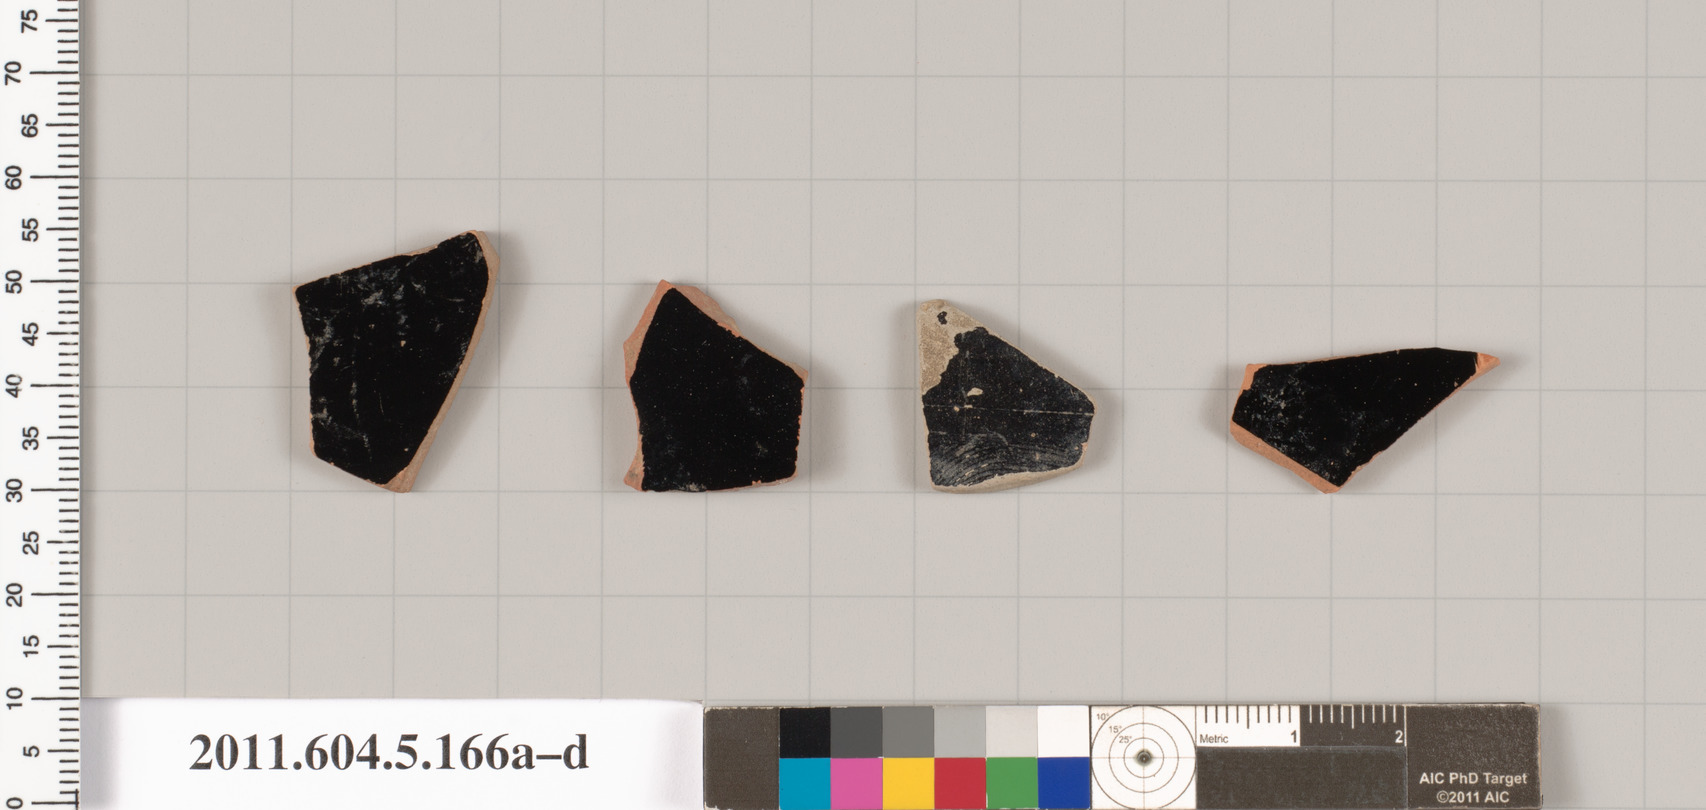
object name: kylix fragment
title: Terracotta fragments of kylikes (drinking cups)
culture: greek, attic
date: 600-401 BCE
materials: terracotta